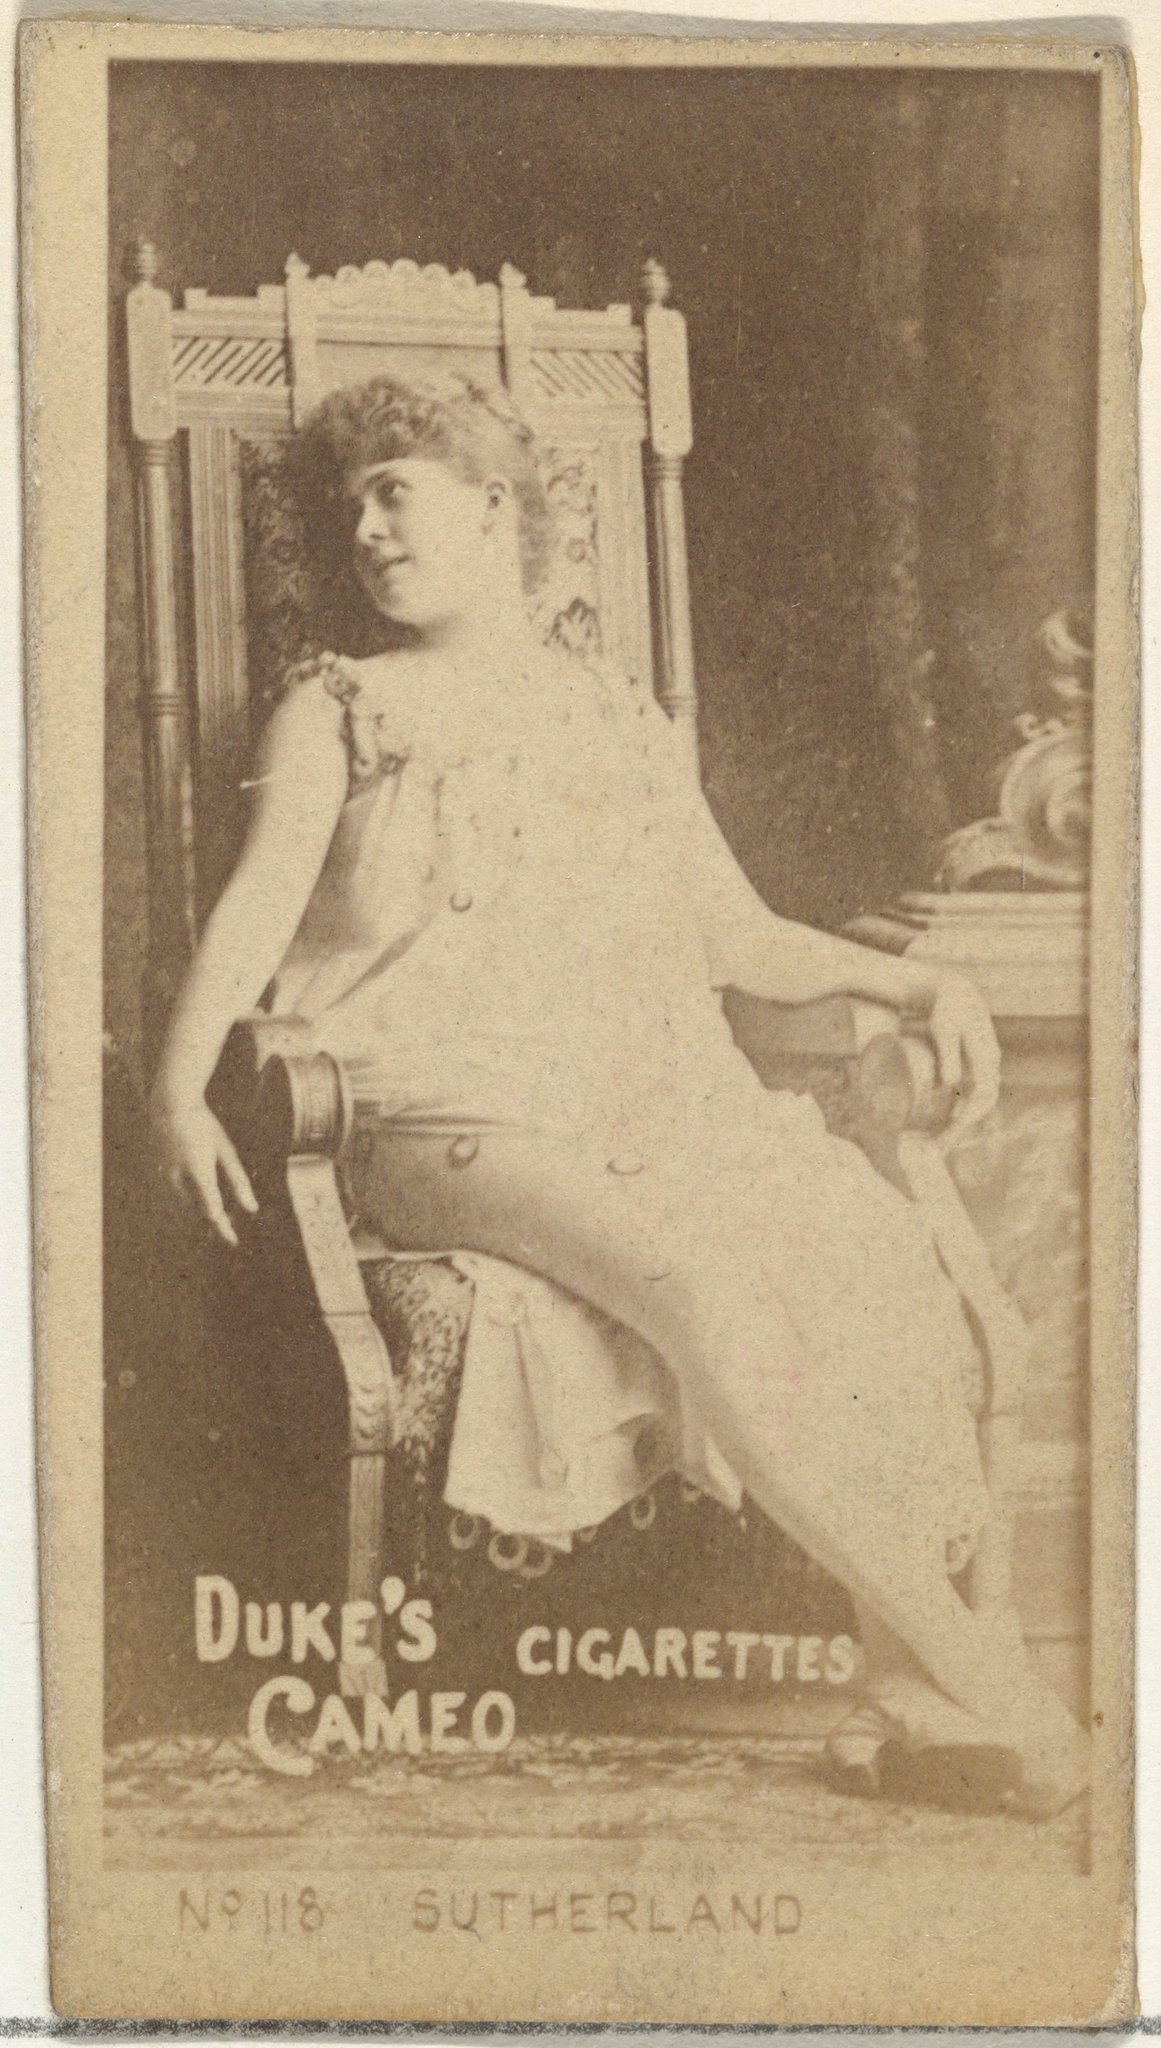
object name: photograph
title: Card Number 118, Annie Sutherland, from the Actors and Actresses series (N145-4) issued by Duke Sons & Co. to promote Cameo Cigarettes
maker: w. duke, sons & co.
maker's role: publisher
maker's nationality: american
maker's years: 1870-1920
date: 1880-1889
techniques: albumen silver print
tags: women,actresses